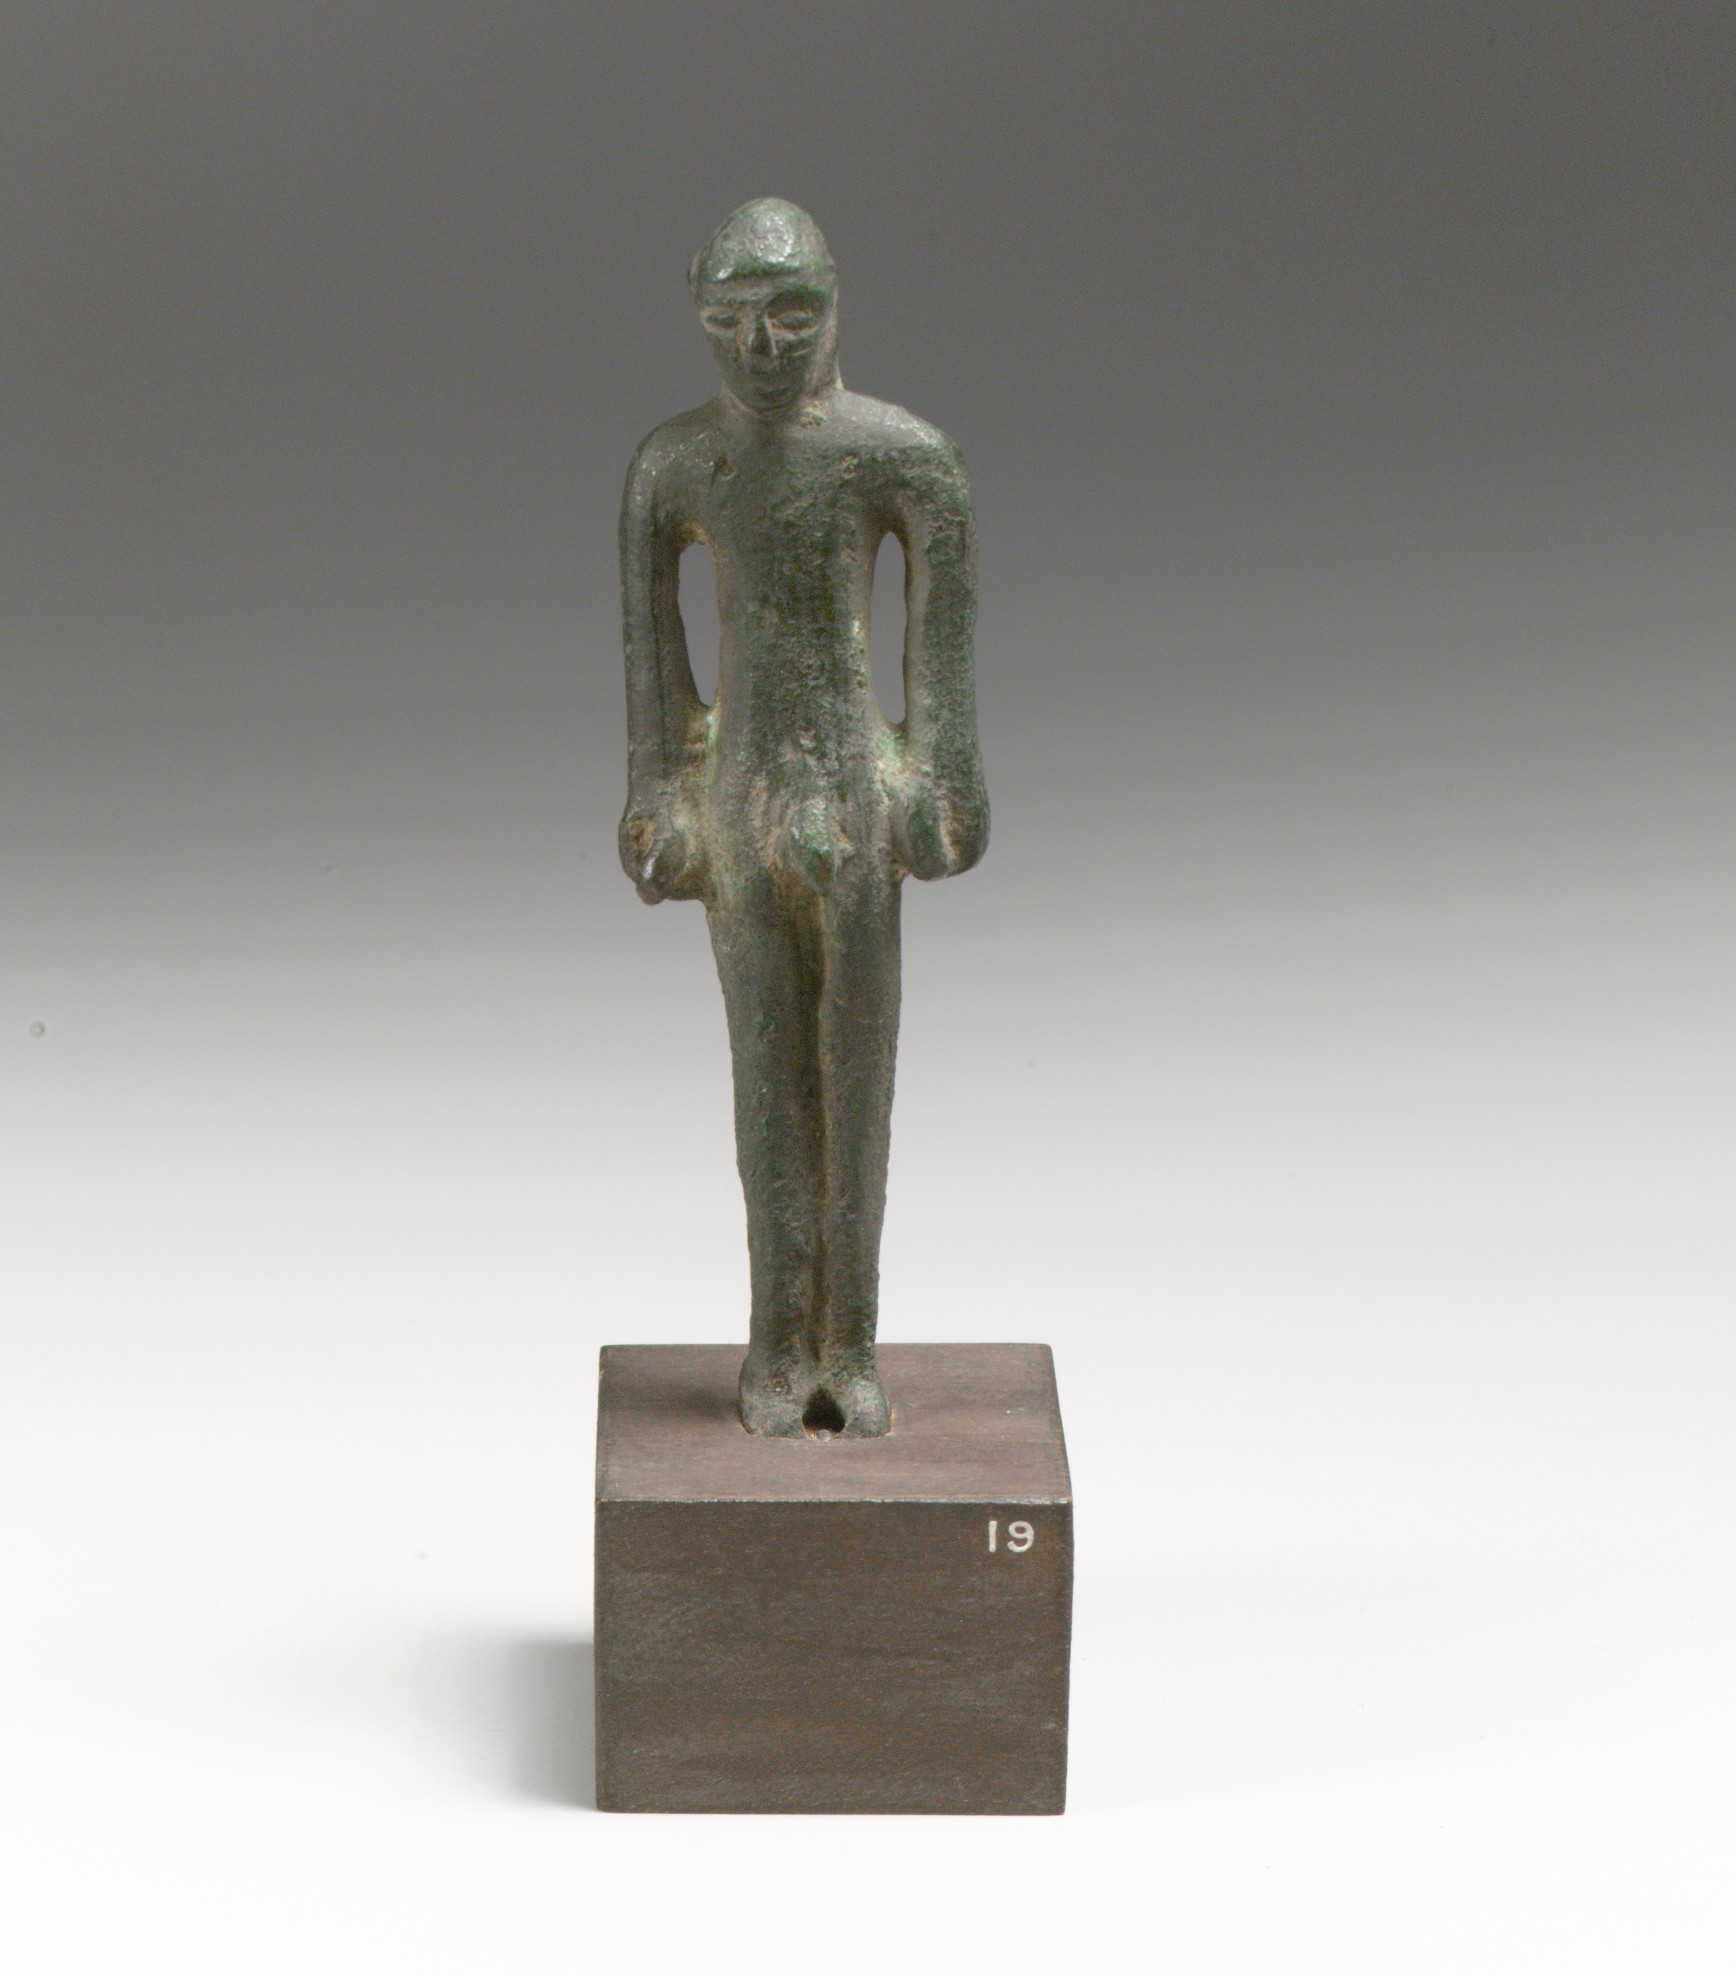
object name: statuette of a youth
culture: etruscan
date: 600-501 BCE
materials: bronze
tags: male nudes